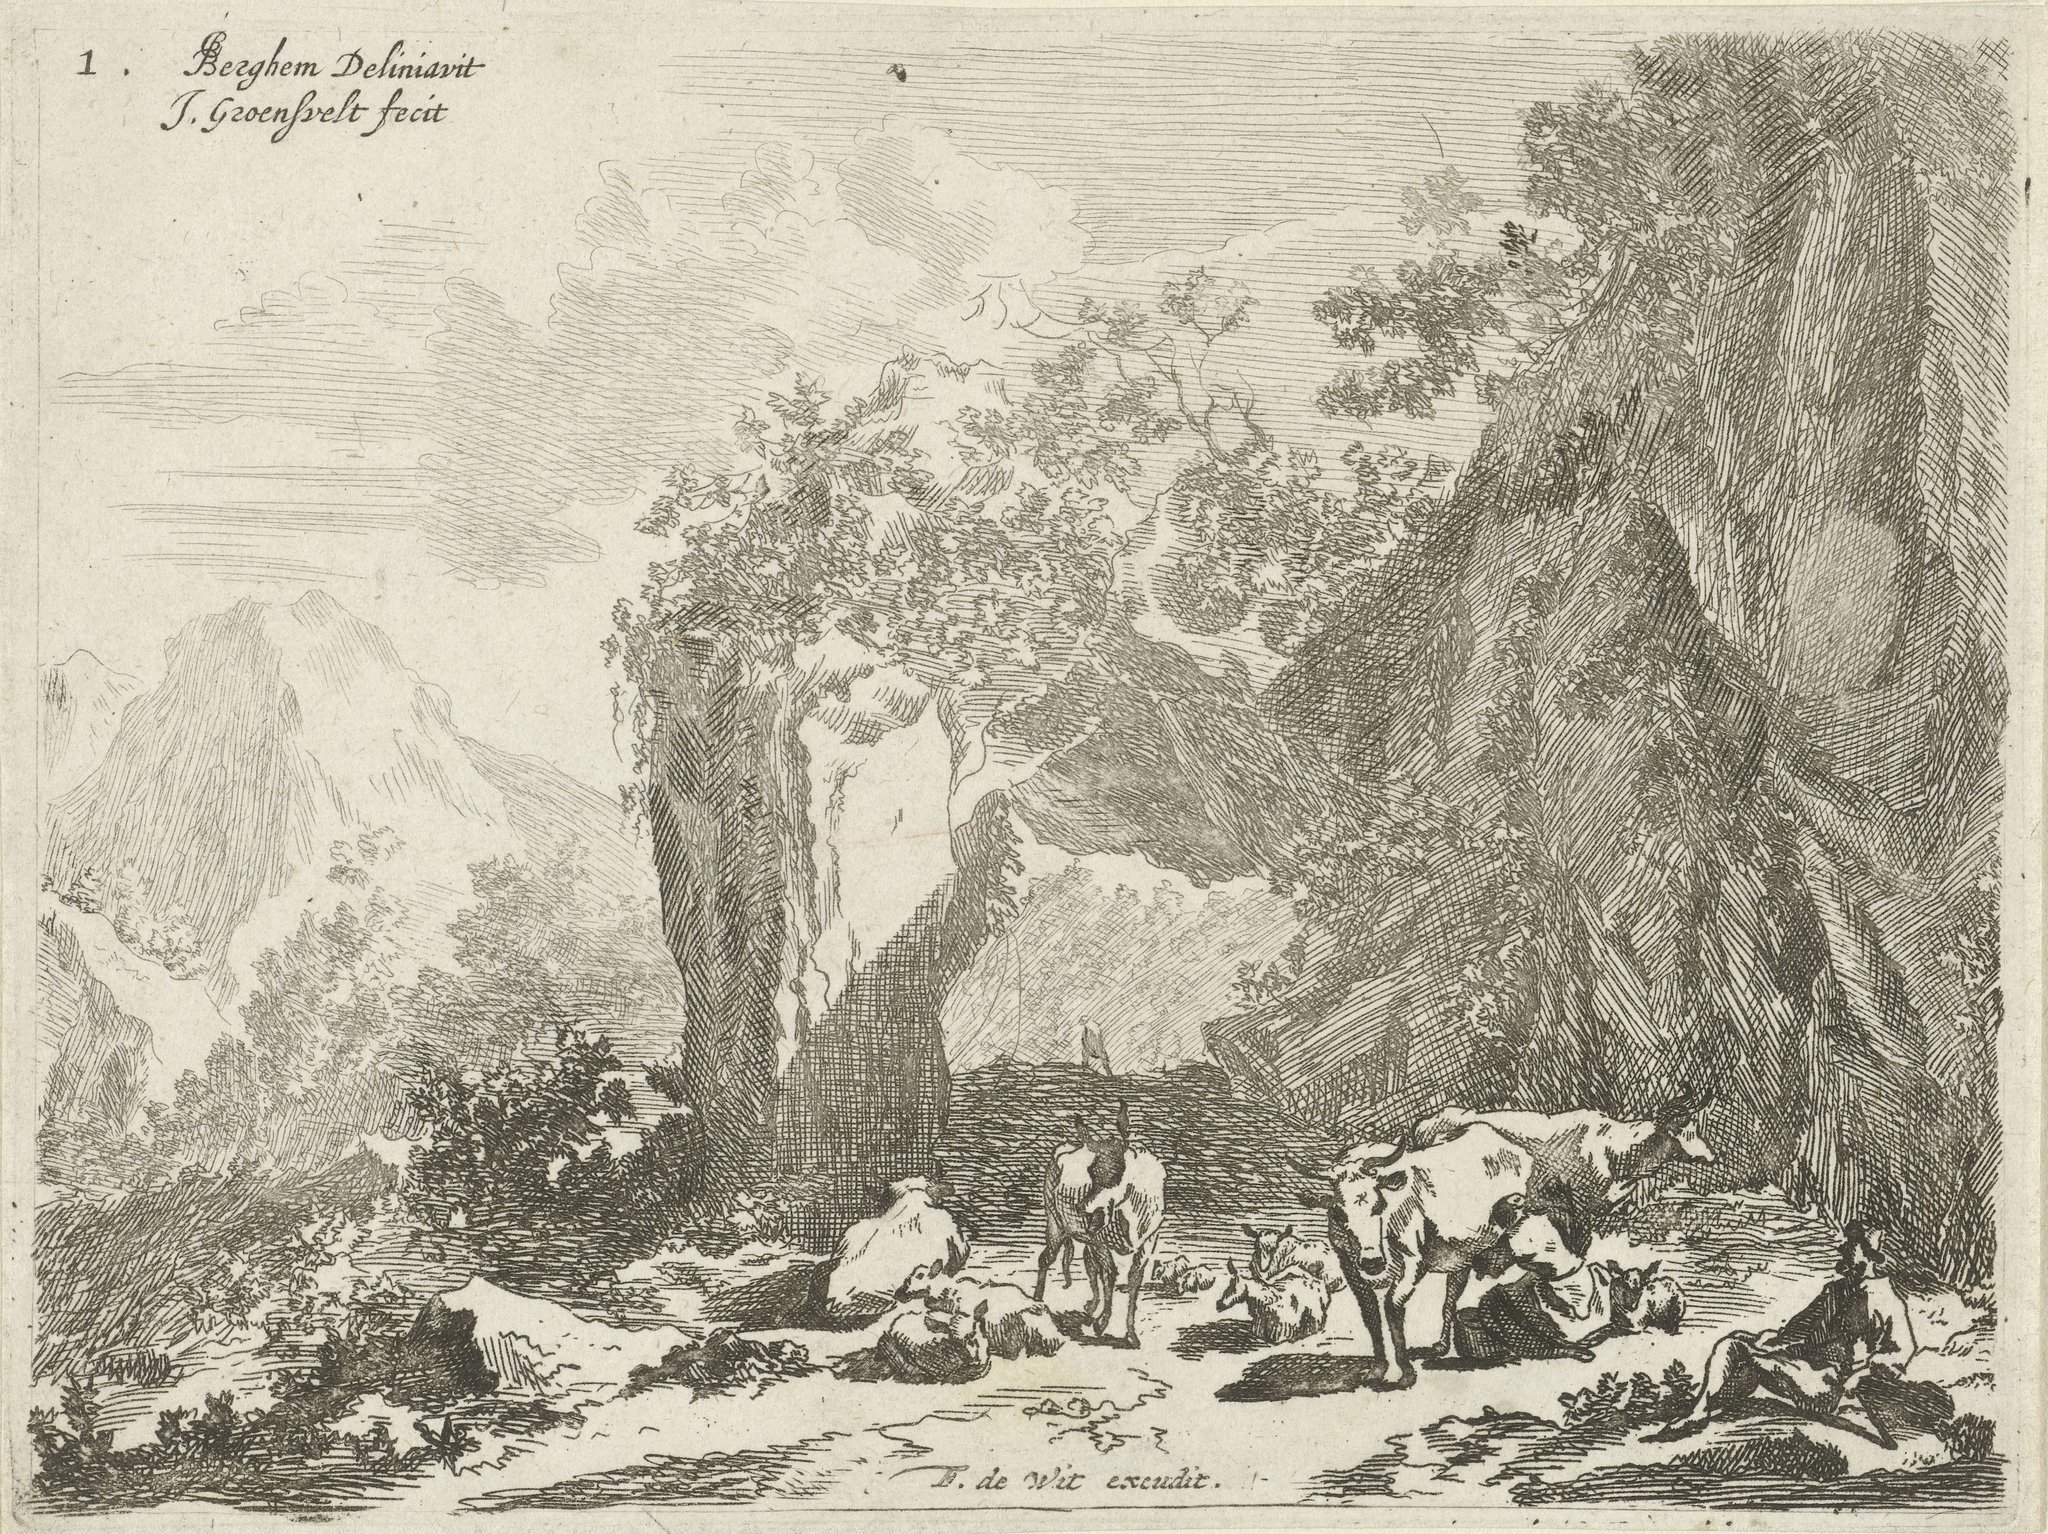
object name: titelprent, frontispice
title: Landschappen met herders en vee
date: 1679-1728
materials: paper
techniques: engraving, etching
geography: amsterdam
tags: landscapes (+ landscape with figures, staffage), groups of animals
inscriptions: collector's mark: Lugt 240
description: Bergachtig landschap met vee. Rechts een koe melkende vrouw en een herder leunend tegen een steen. Eerste prent uit een serie van vier met landschappen met herders en vee.